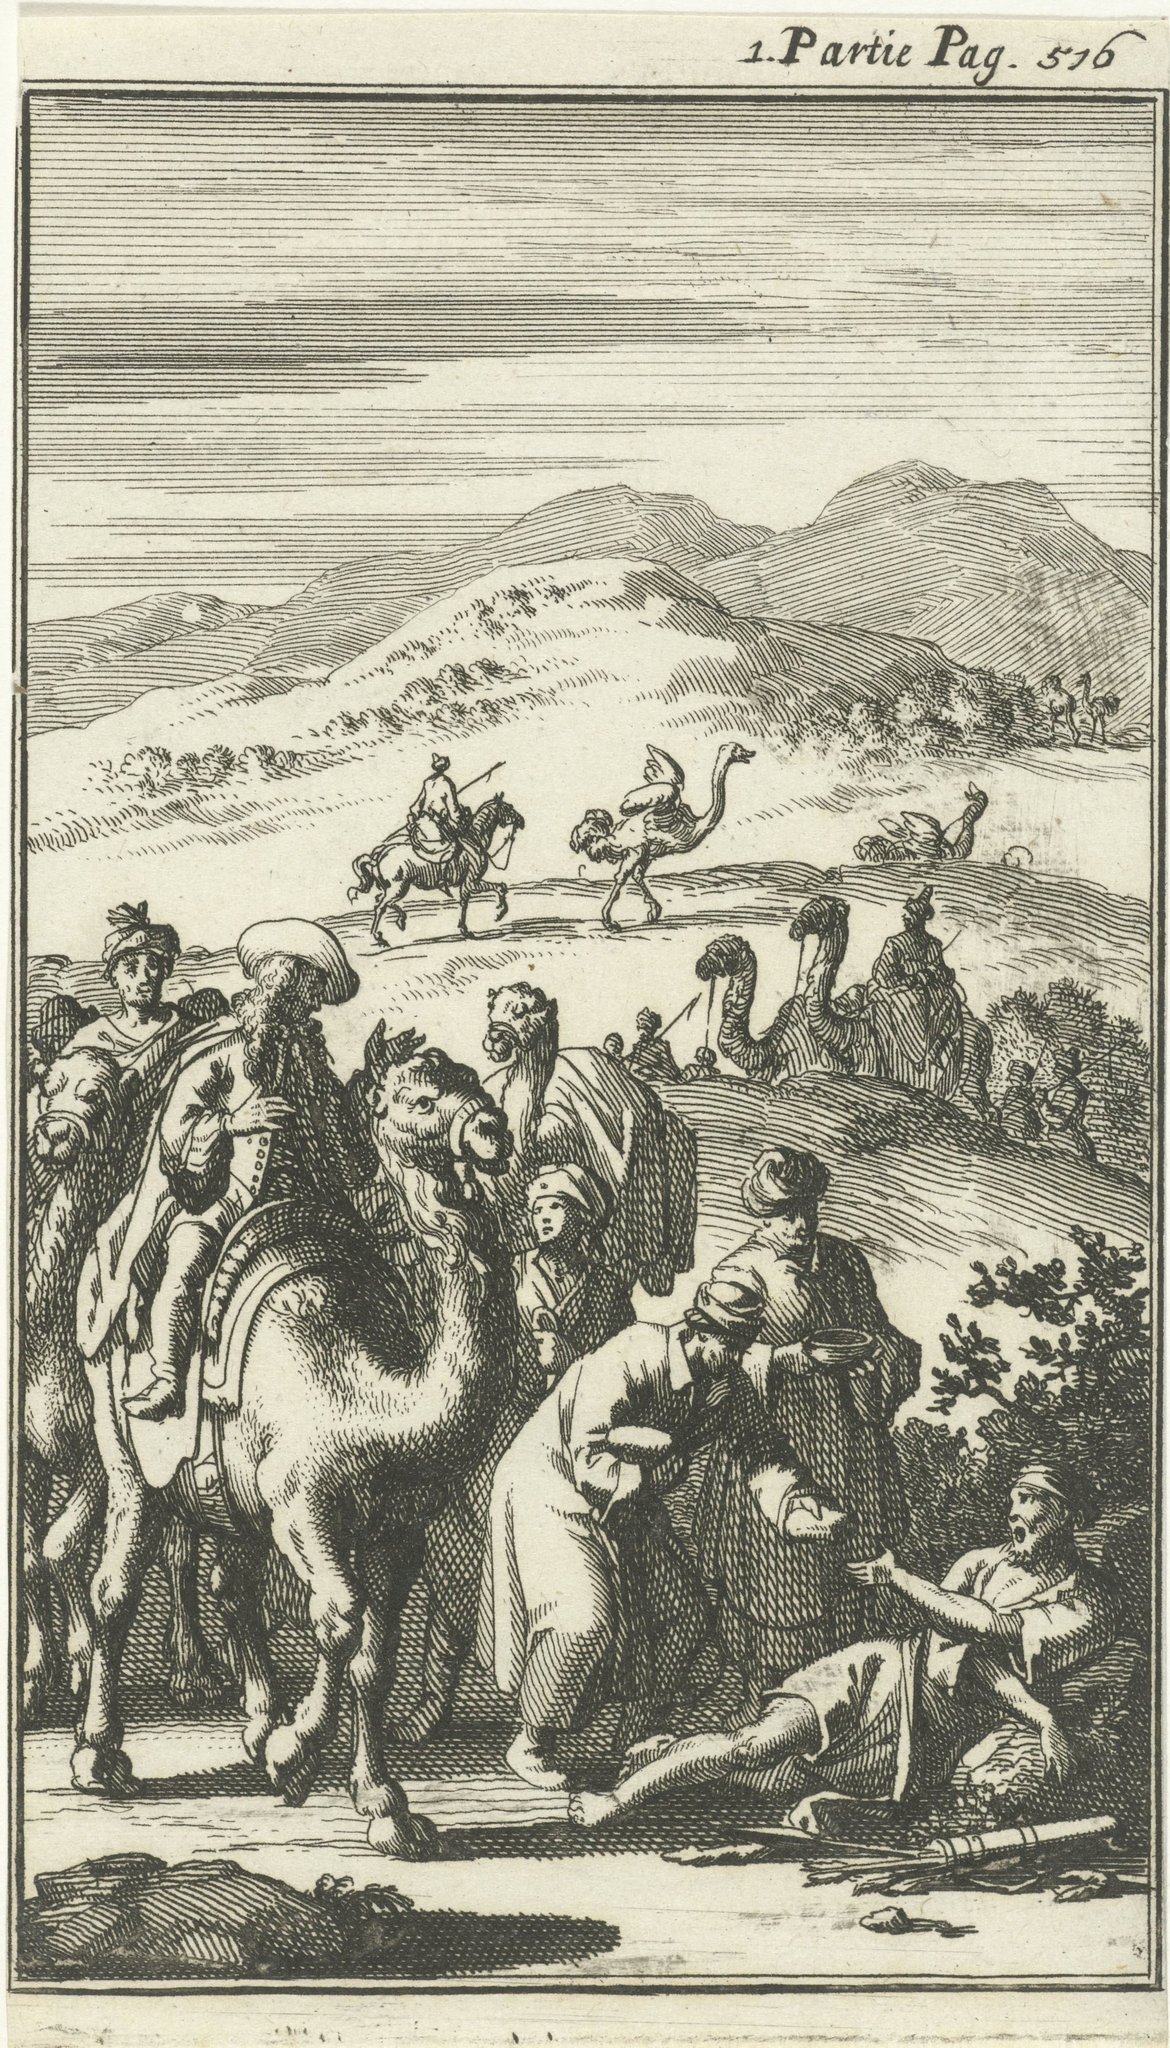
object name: print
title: Karavaan vindt onderweg een zieke Arabier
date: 1689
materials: paper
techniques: etching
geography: paris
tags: trading expedition, hoofed animals: camel, patient, sick person, 'en route', traveller under way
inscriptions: collector's mark: Lugt 2228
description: Illustratie uit: Thevenot, Jean de. Voyages Tant en Europe qu'en Asie et en Afrique, 4 delen. Parijs: Charles Angot, 1689, dl. II.